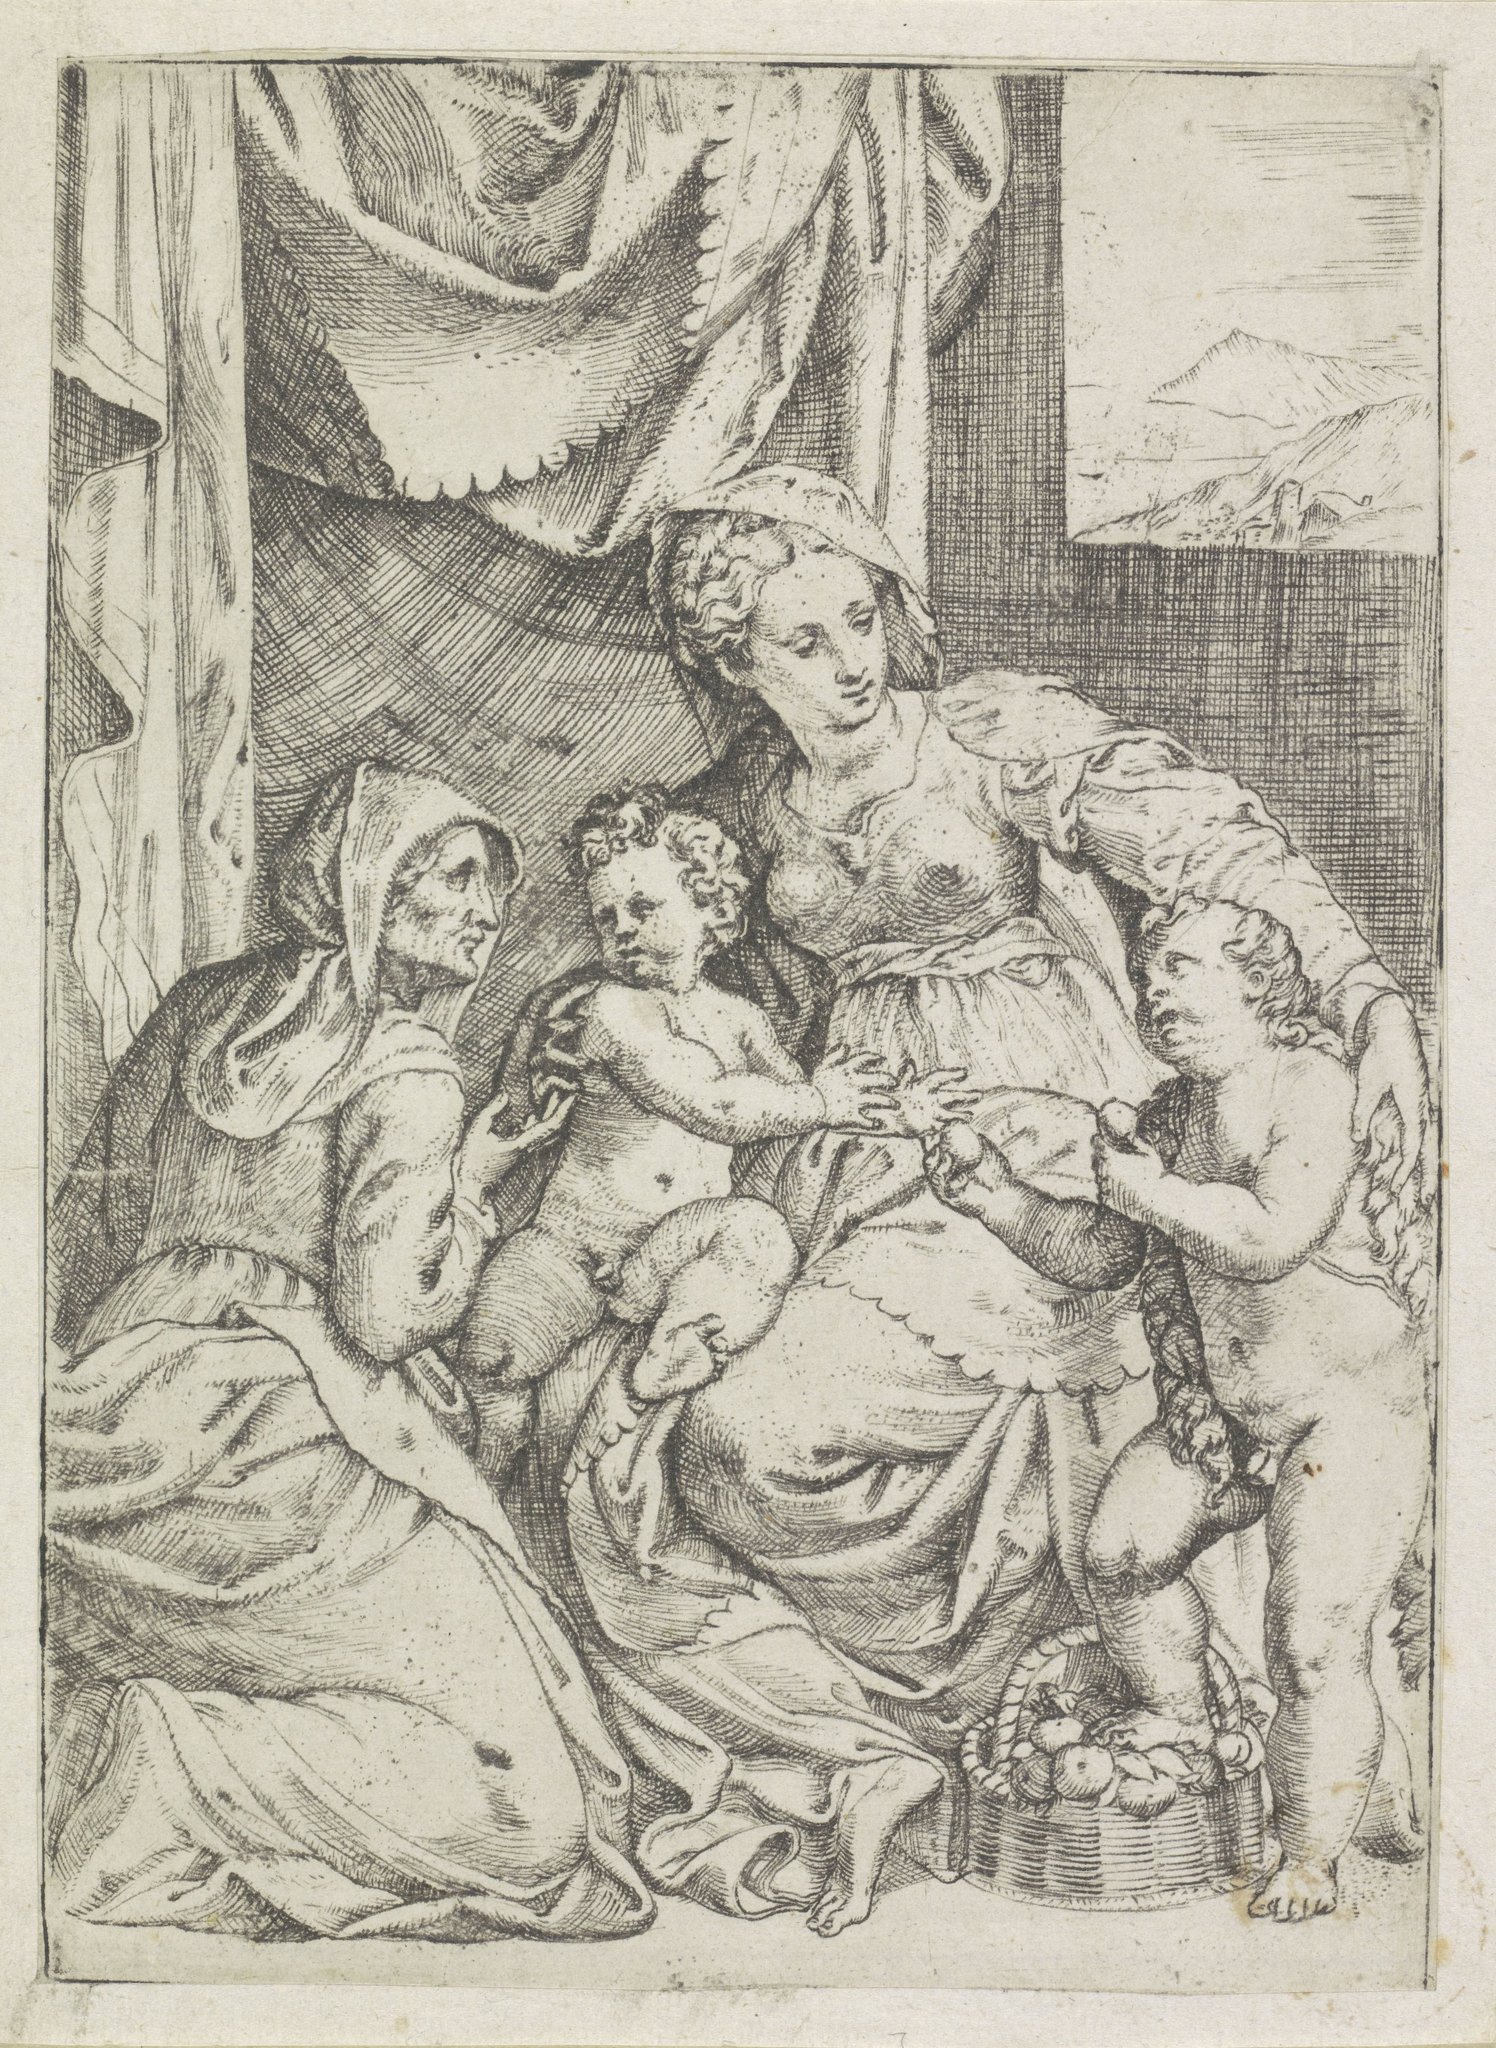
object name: print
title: Maria met Kind en Elisabet met de jonge Johannes de Doper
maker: angelo falco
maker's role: print maker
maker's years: 1600-1695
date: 1619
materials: paper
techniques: etching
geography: italy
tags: mary, the christ-child and john the baptist, elisabeth present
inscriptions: collector's mark: Lugt 240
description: Maria zit het het Christuskind op schoot. Naast Maria staat de jonge Johannes de Doper met zijn voet op een mand vol fruit. Hij overhandigt een vrucht aan het Christuskind. Op de voorgrond links knielt Elisabet.